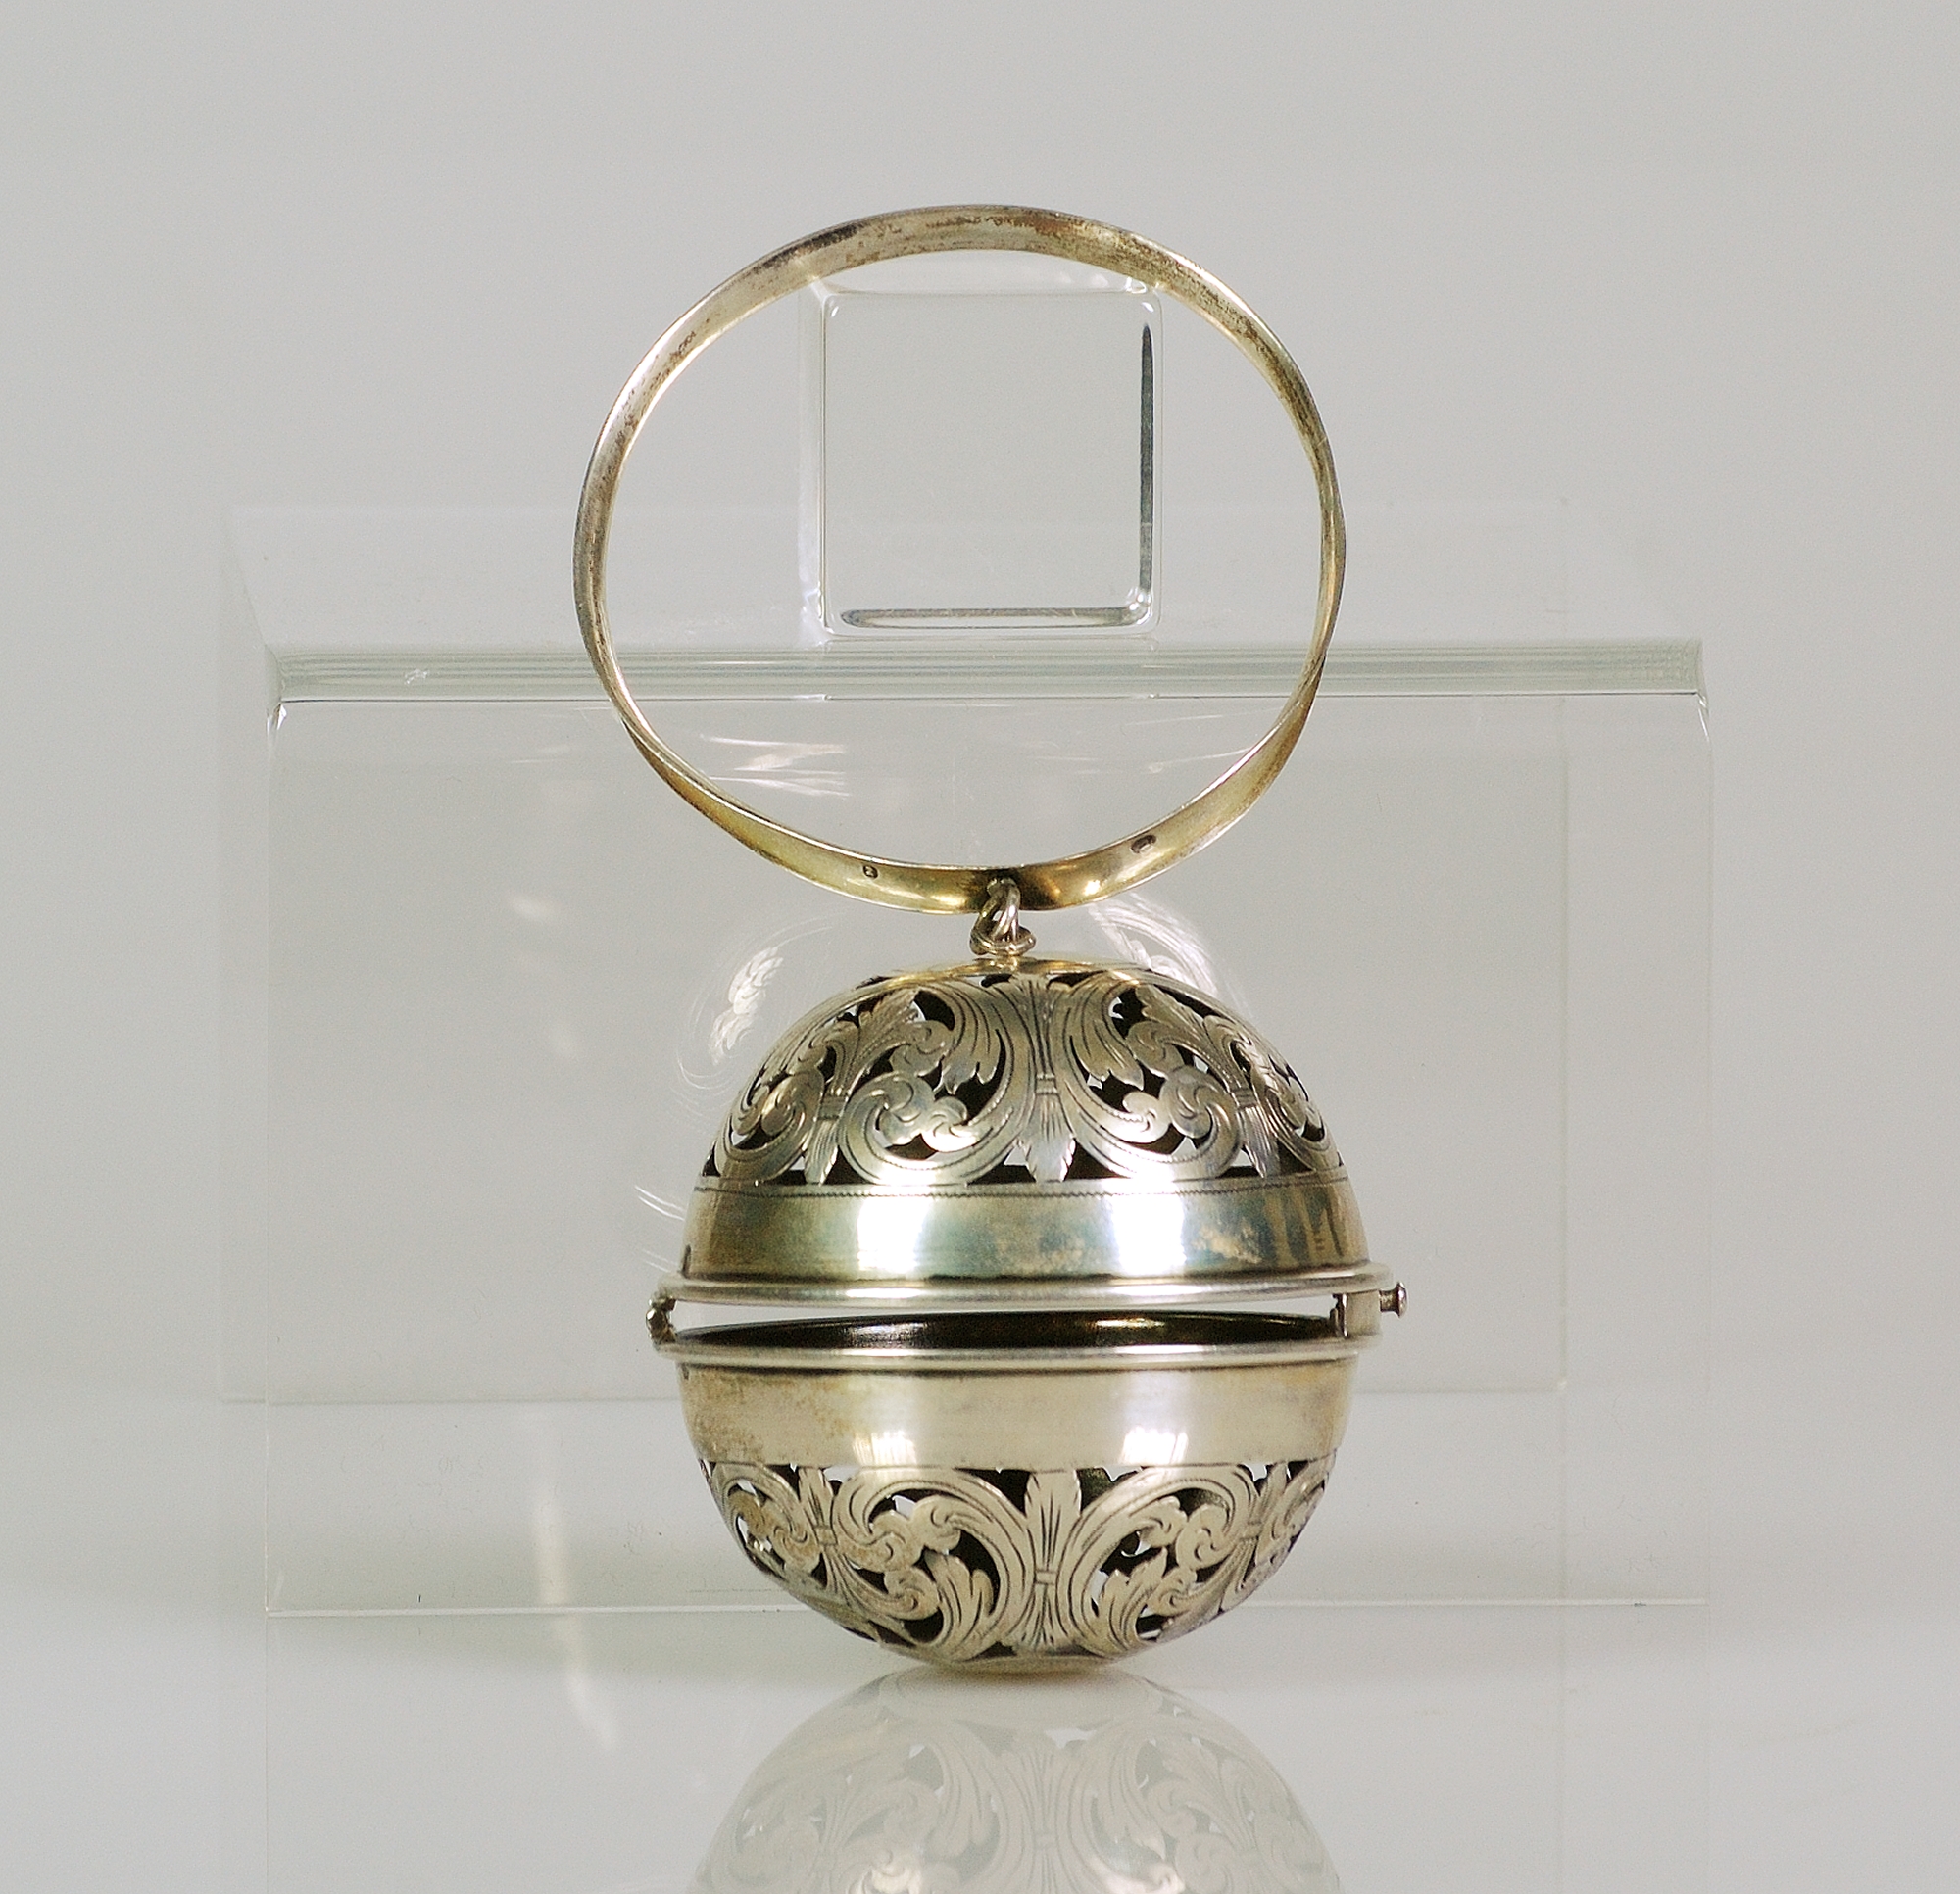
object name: bag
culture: british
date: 1867-1900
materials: metal